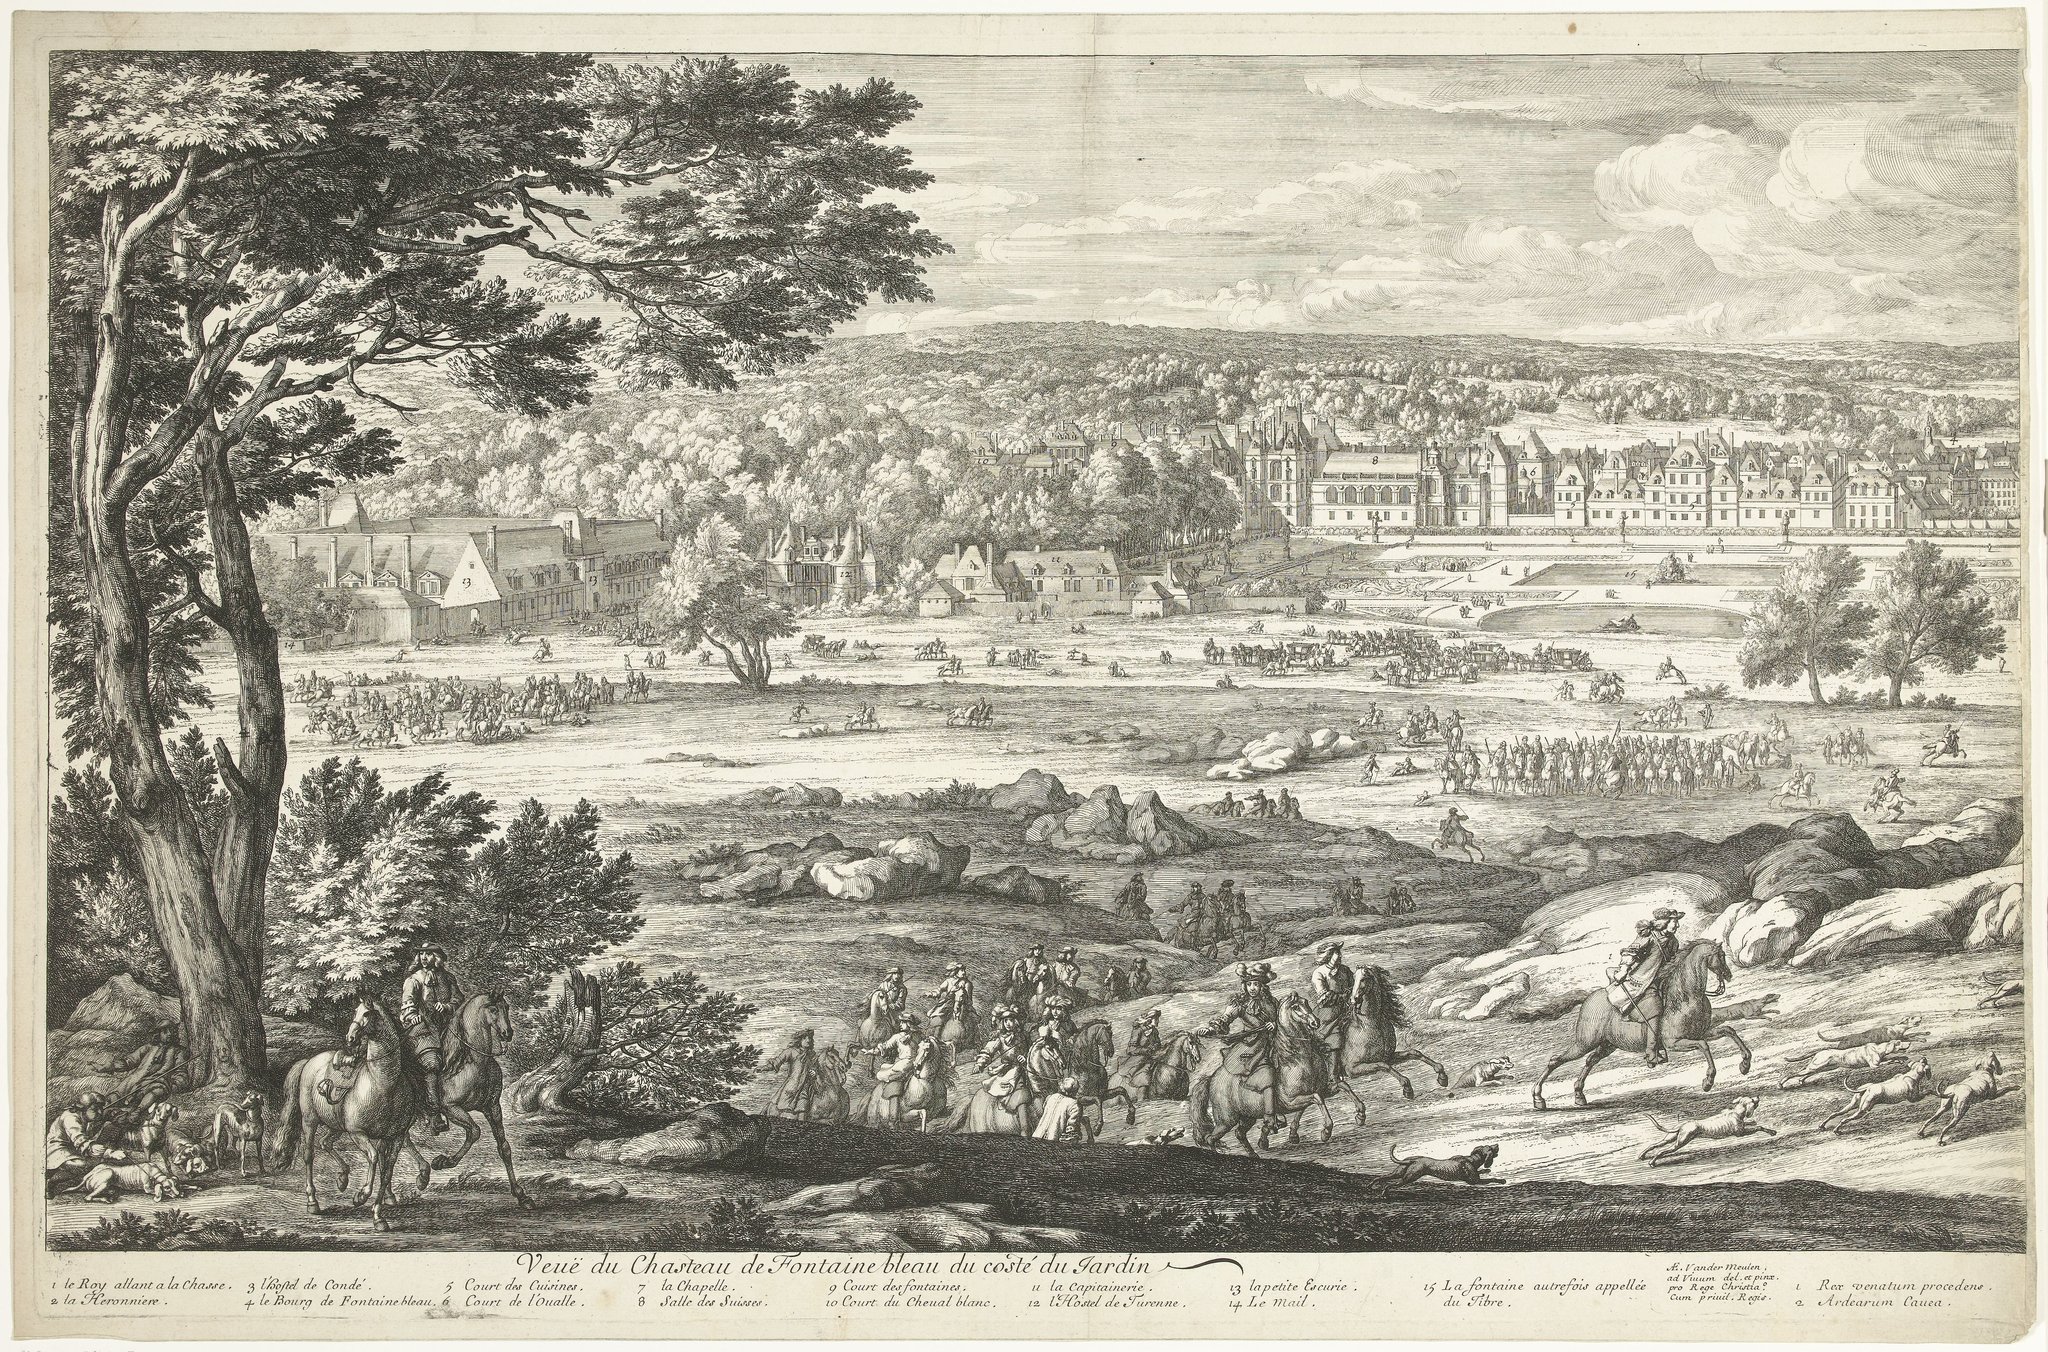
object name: print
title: Veuë du Chasteau de Fontainebleau du costé du Jardin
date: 1666-1681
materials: paper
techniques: etching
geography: paris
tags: castle, landscapes in the temperate zone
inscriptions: collector's mark: Lugt 240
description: Gezicht op kasteel Fontainebleau en de landerijen eromheen. Op de voorgrond een groep jagers. Op de weg bij de tuinen van het kasteel staan koetsen klaar.